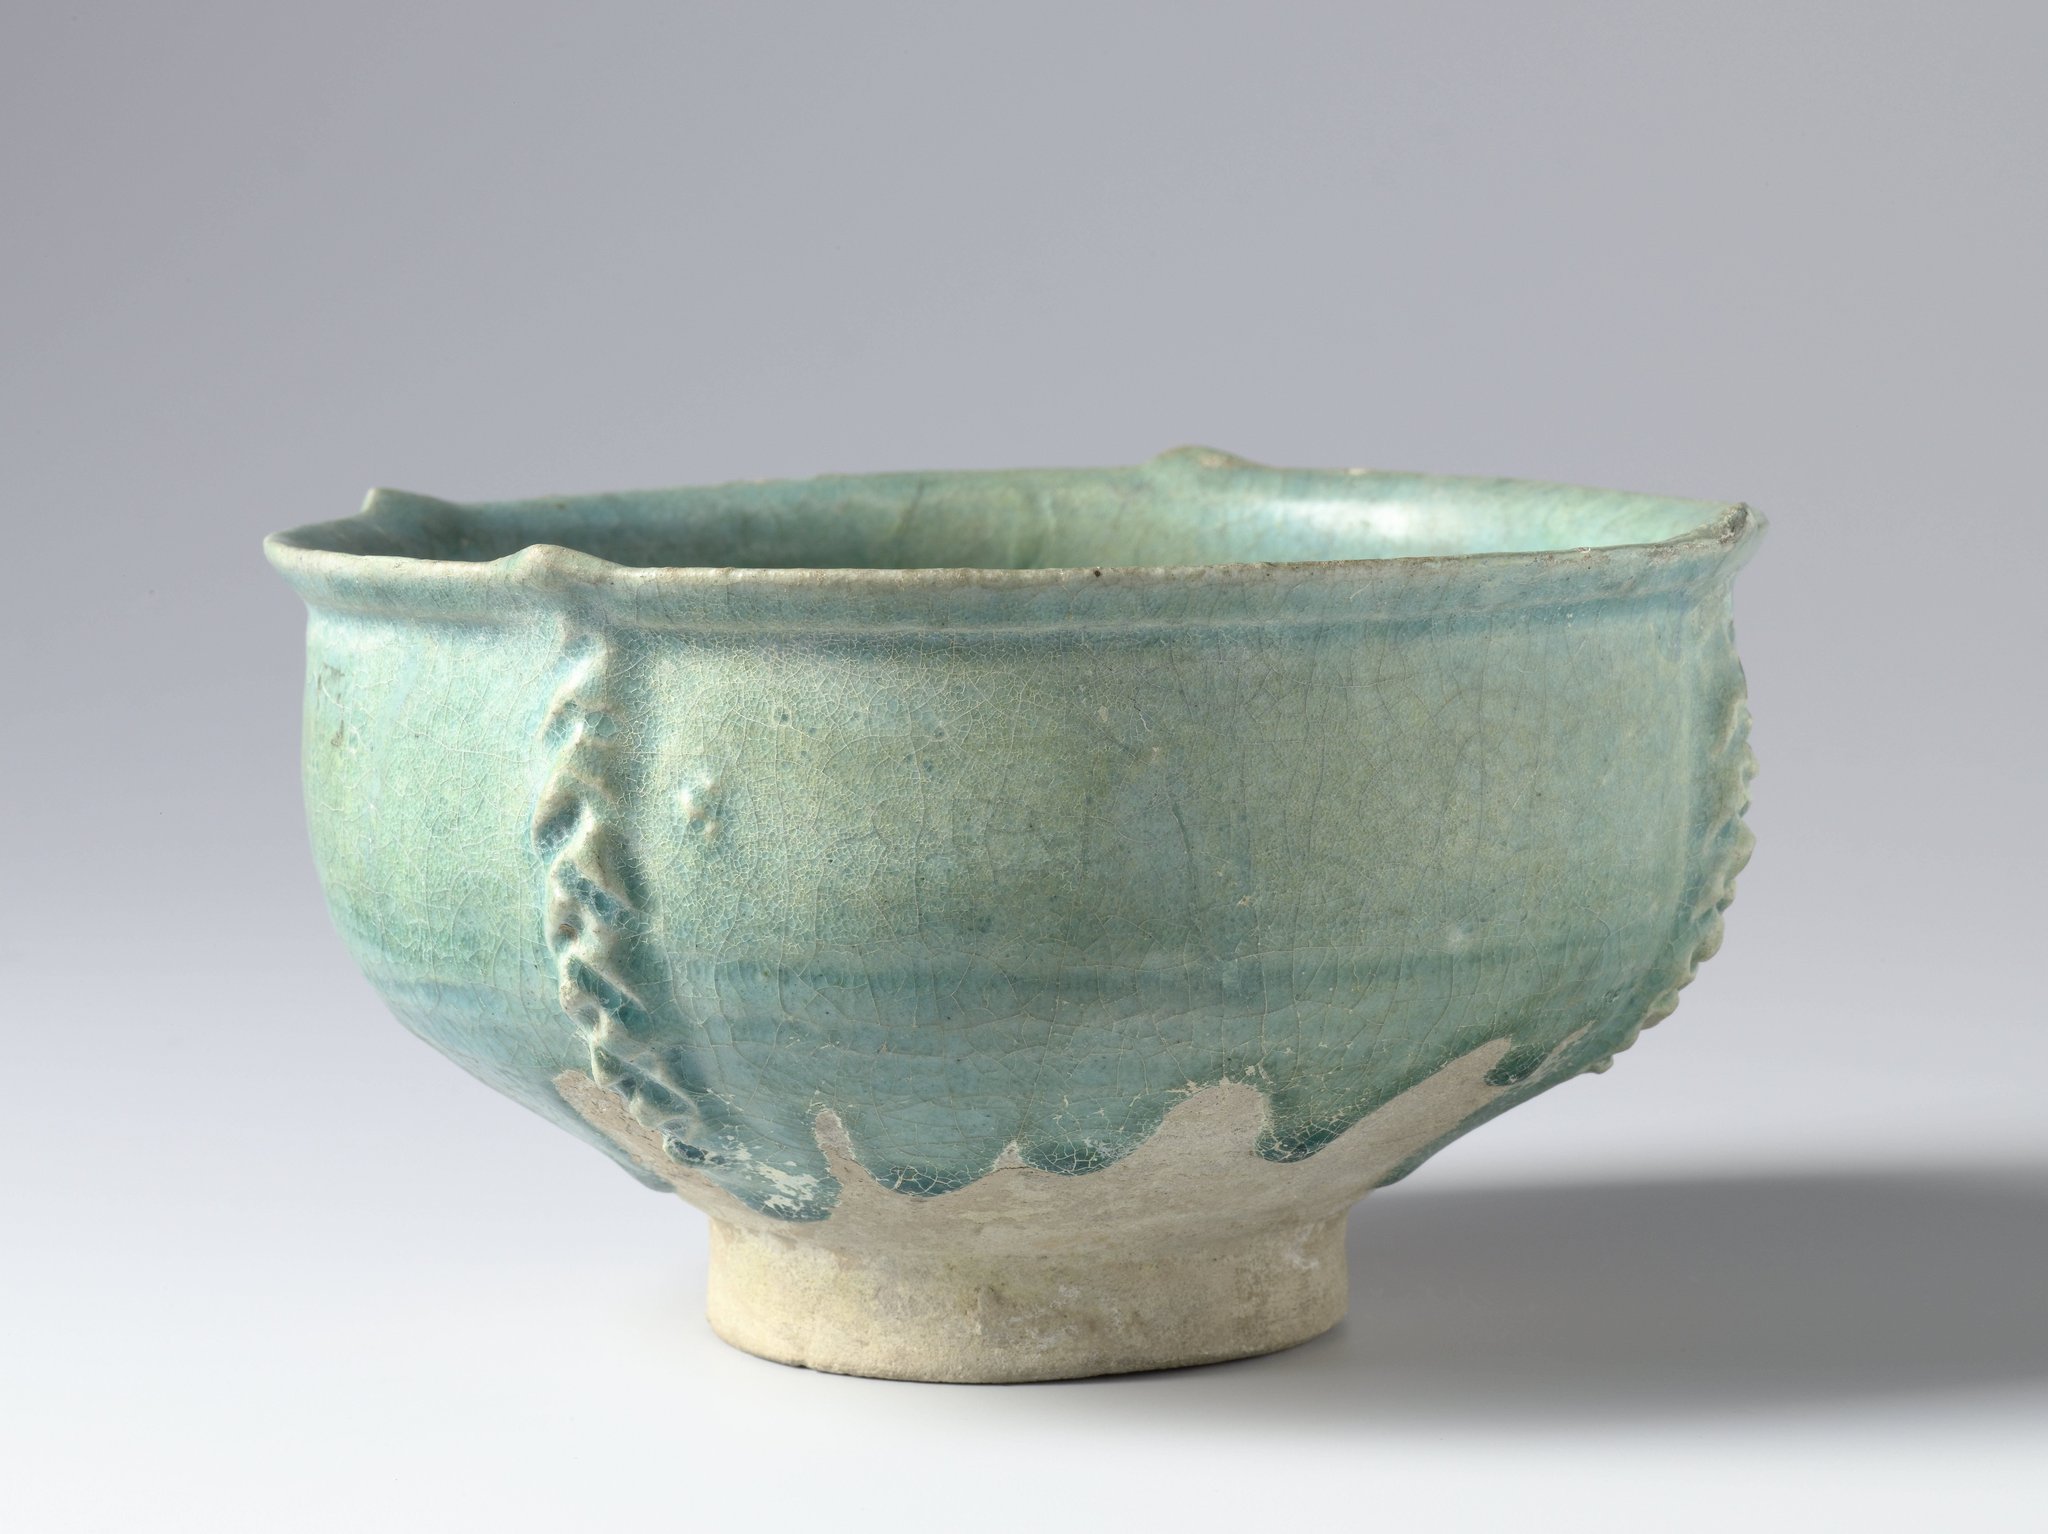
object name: bowl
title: Bowl with moulded bands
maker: Anonymous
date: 1100-1299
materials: earthenware, glaze, quartz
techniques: firing, molding, vitrification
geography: iran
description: Kom van kwarts-fritgoed bedekt met een monochroom turquoise glazuur; vier gemodelleerde banden met vlechtwerk op de buitenwand.